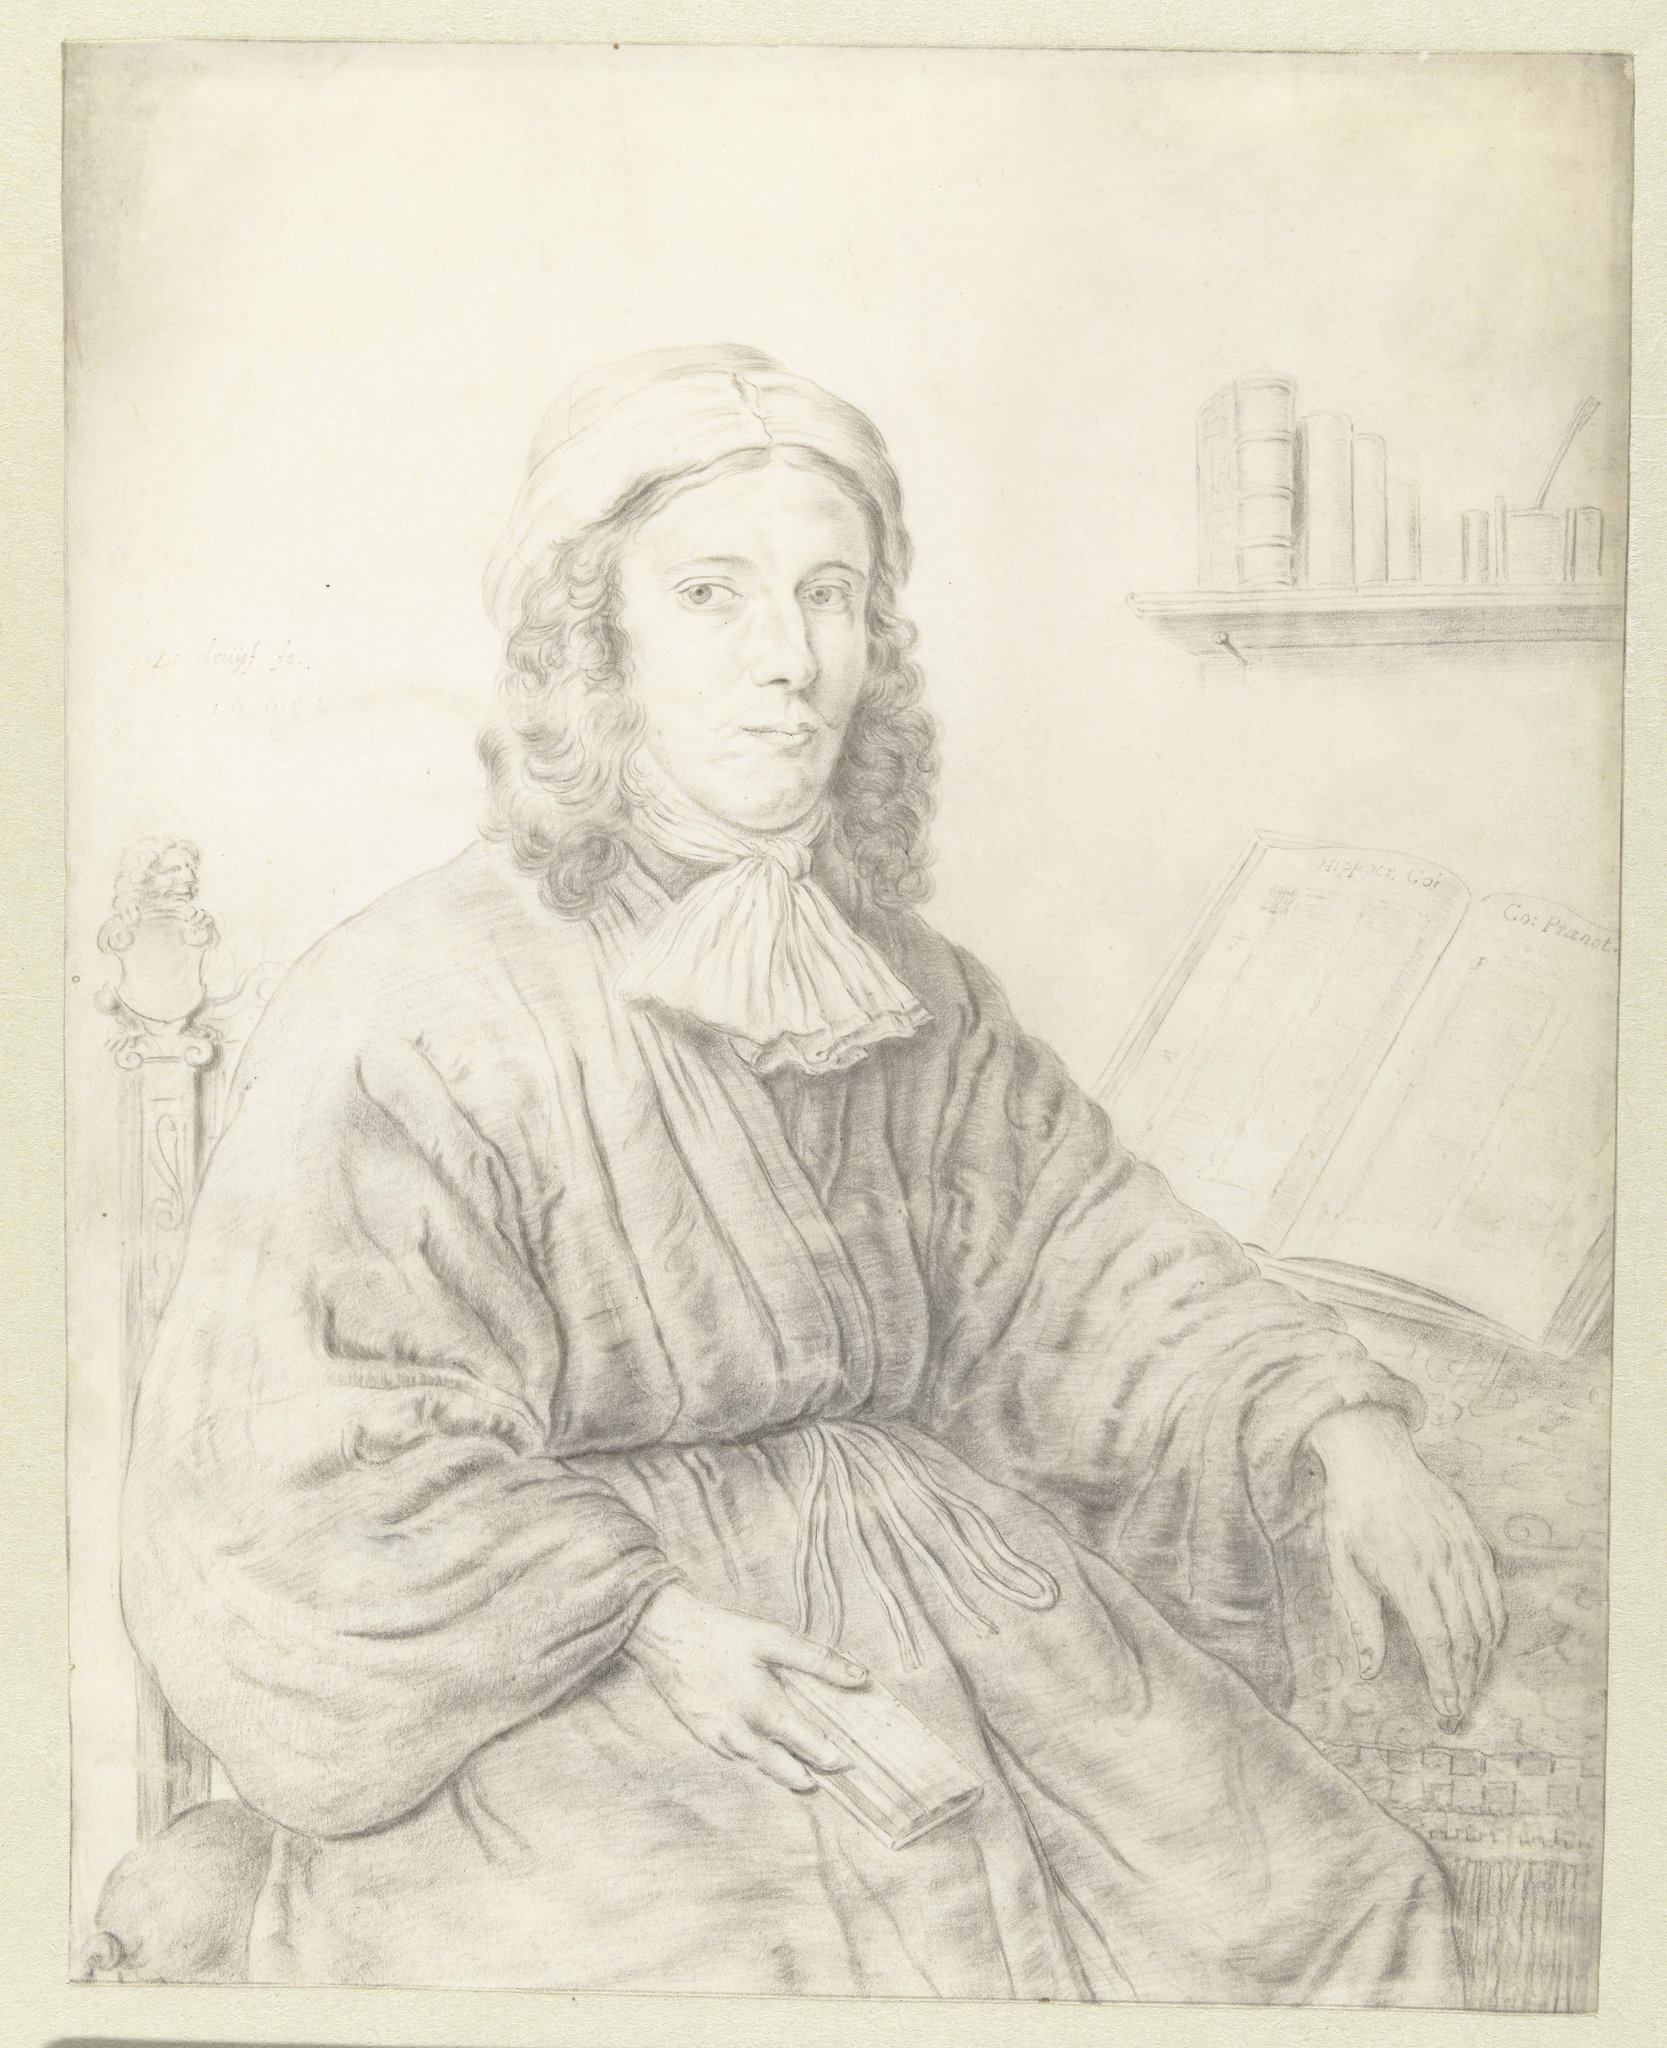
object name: drawing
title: Portret van C. te 's-Gravezande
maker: dirk druyf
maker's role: painter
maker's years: 1620-1659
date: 1666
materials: graphite, parchment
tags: arts, cornelius 's- gravesande